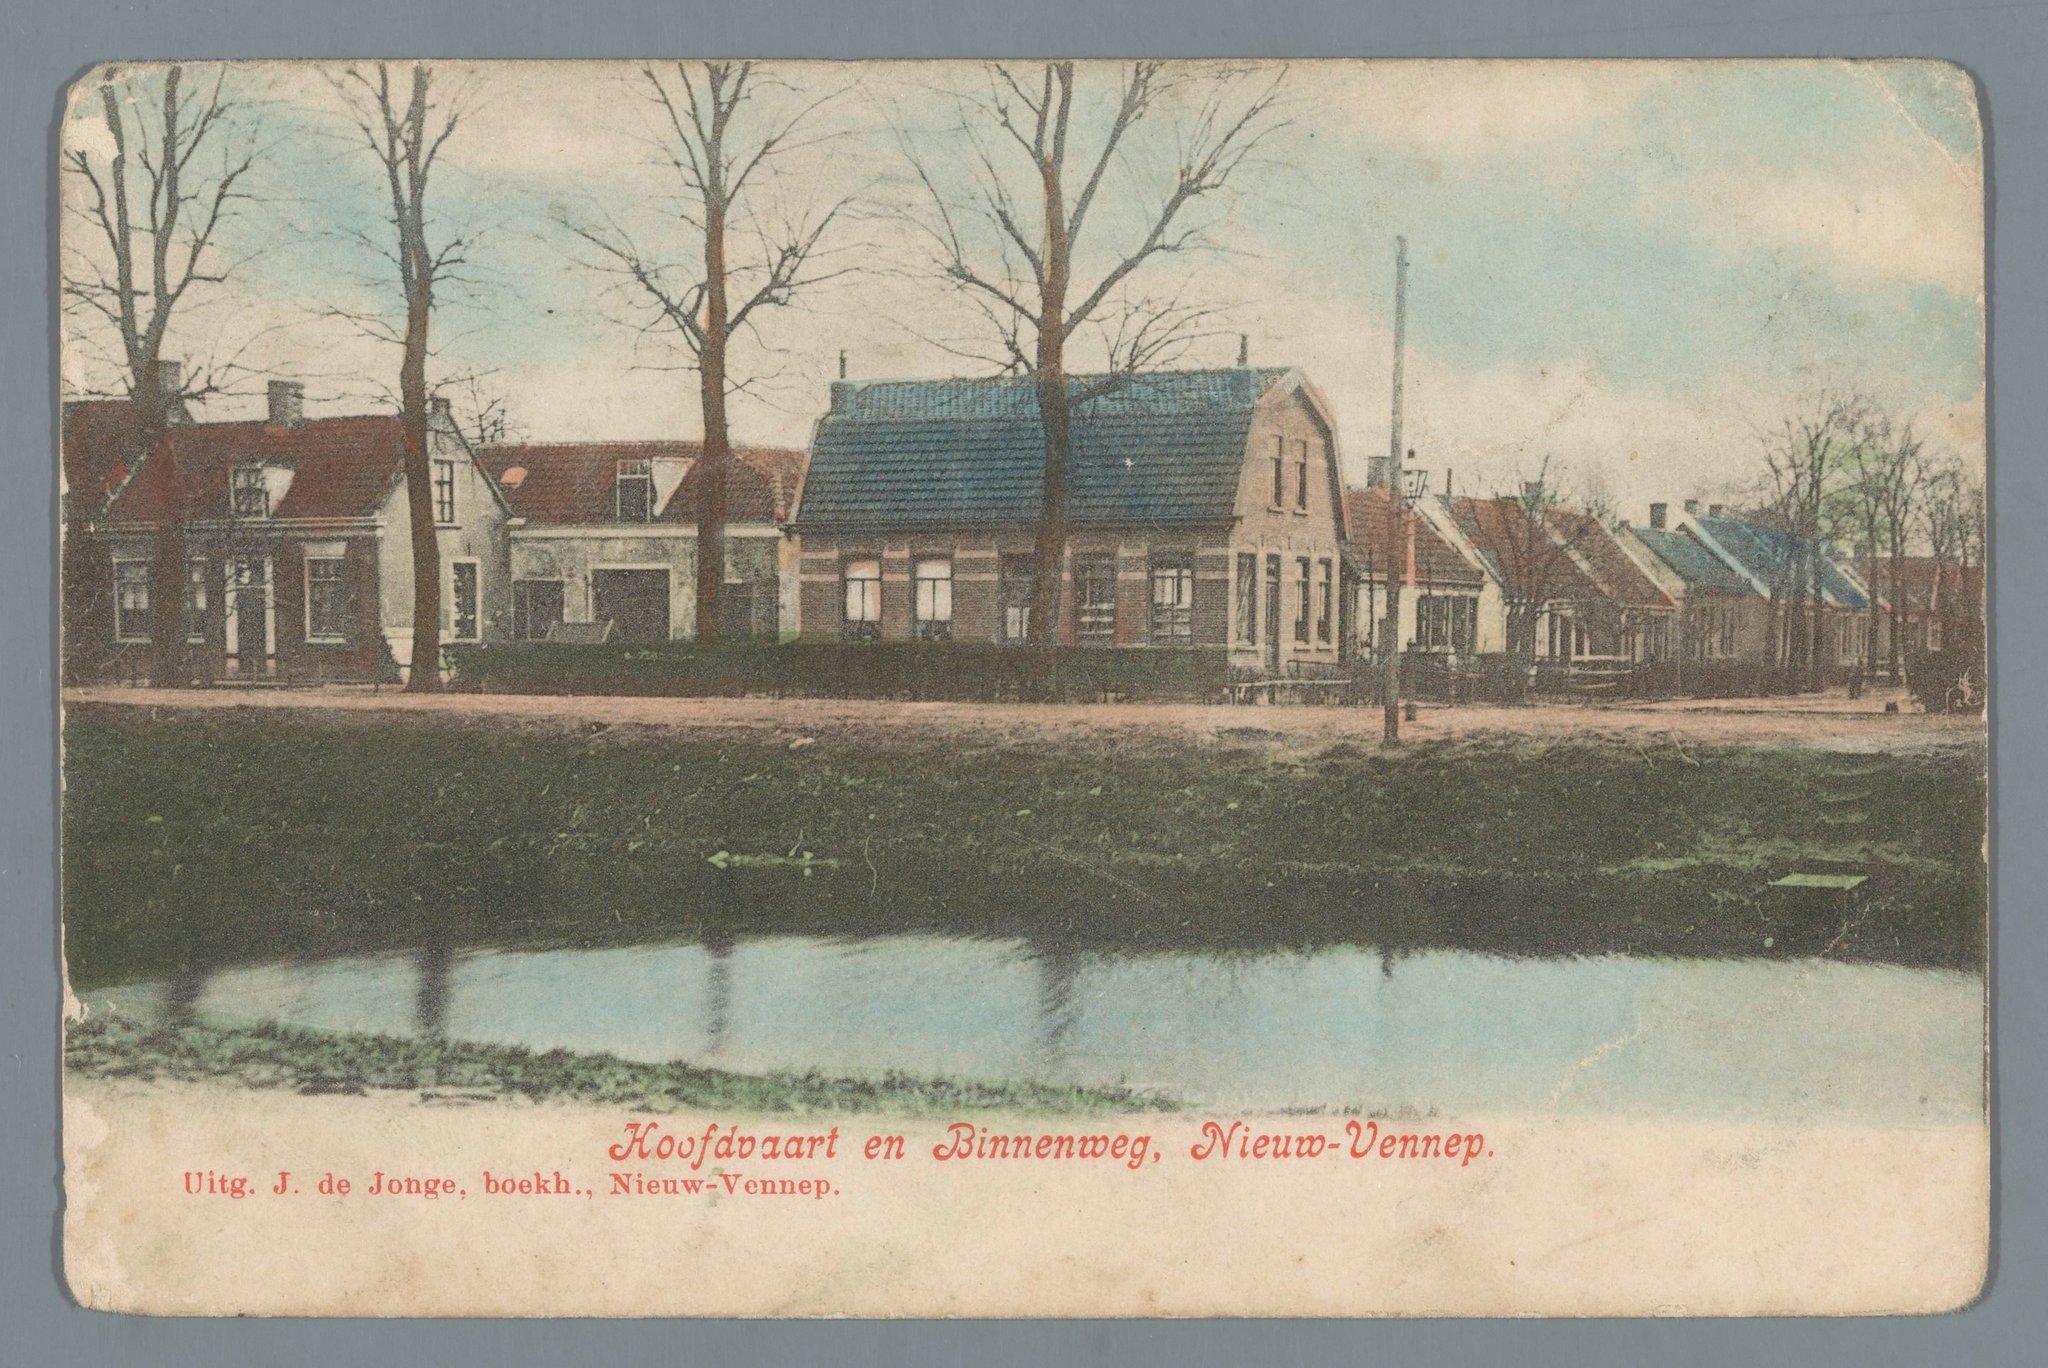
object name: ansichtkaart, prentbriefkaart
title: Hoofdvaart en Binnenweg, Nieuw-Vennep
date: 1890-1920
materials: cardboard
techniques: photograph, writing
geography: nieuw-vennep